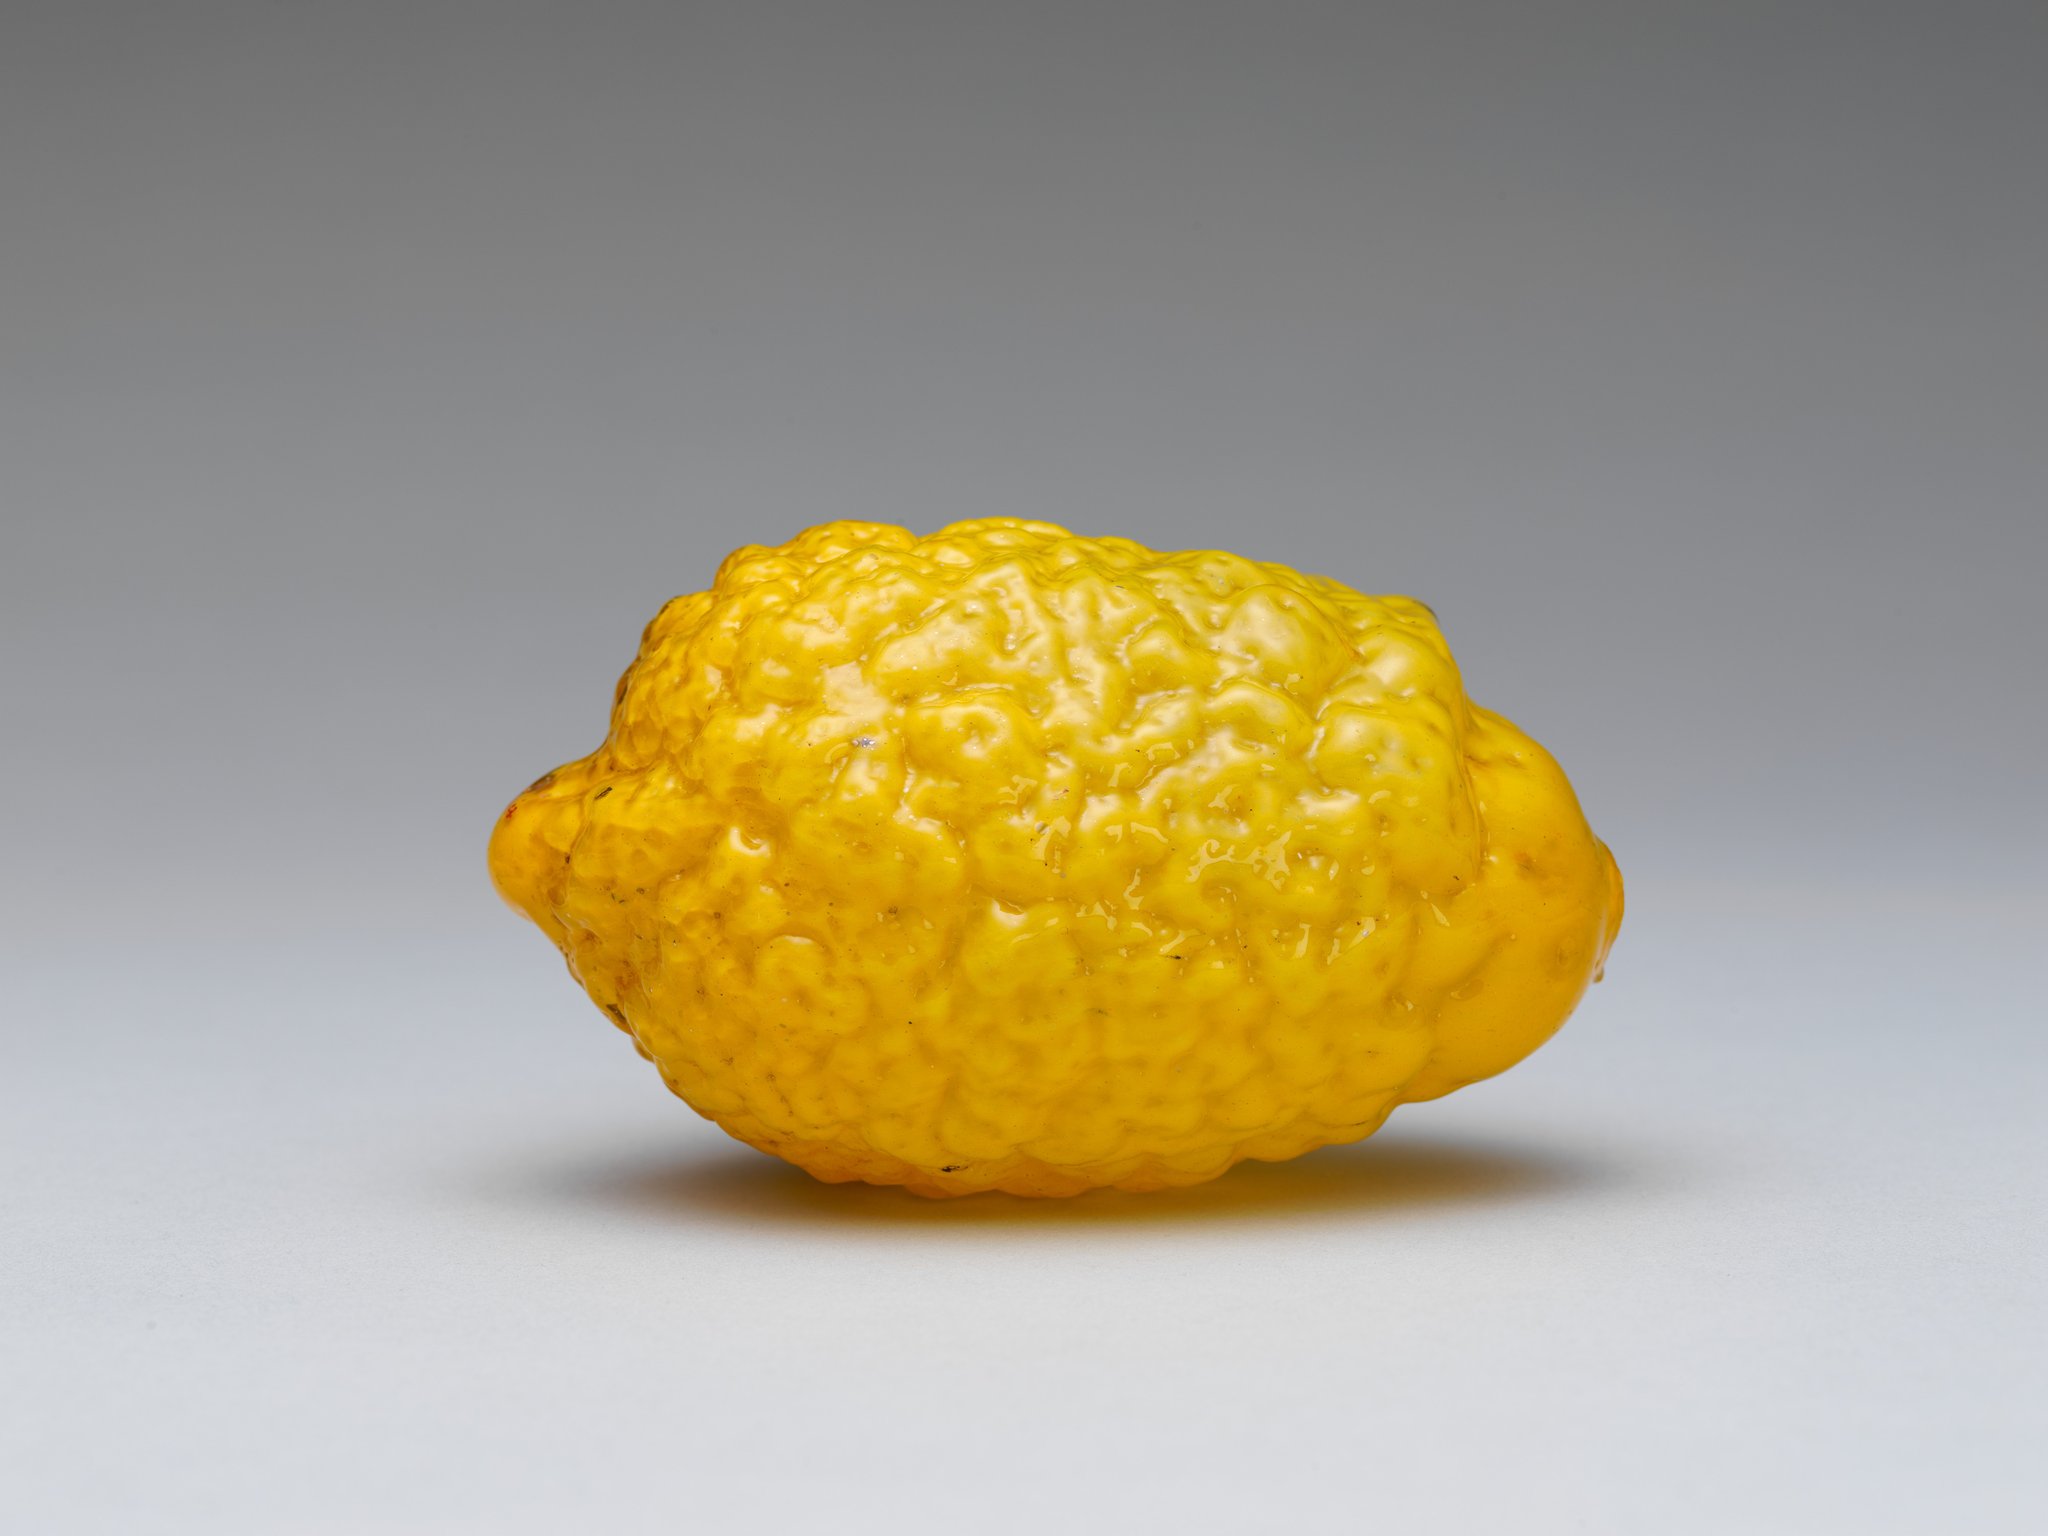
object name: citron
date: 1701-1900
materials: glass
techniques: glassblowing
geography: italy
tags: fruit